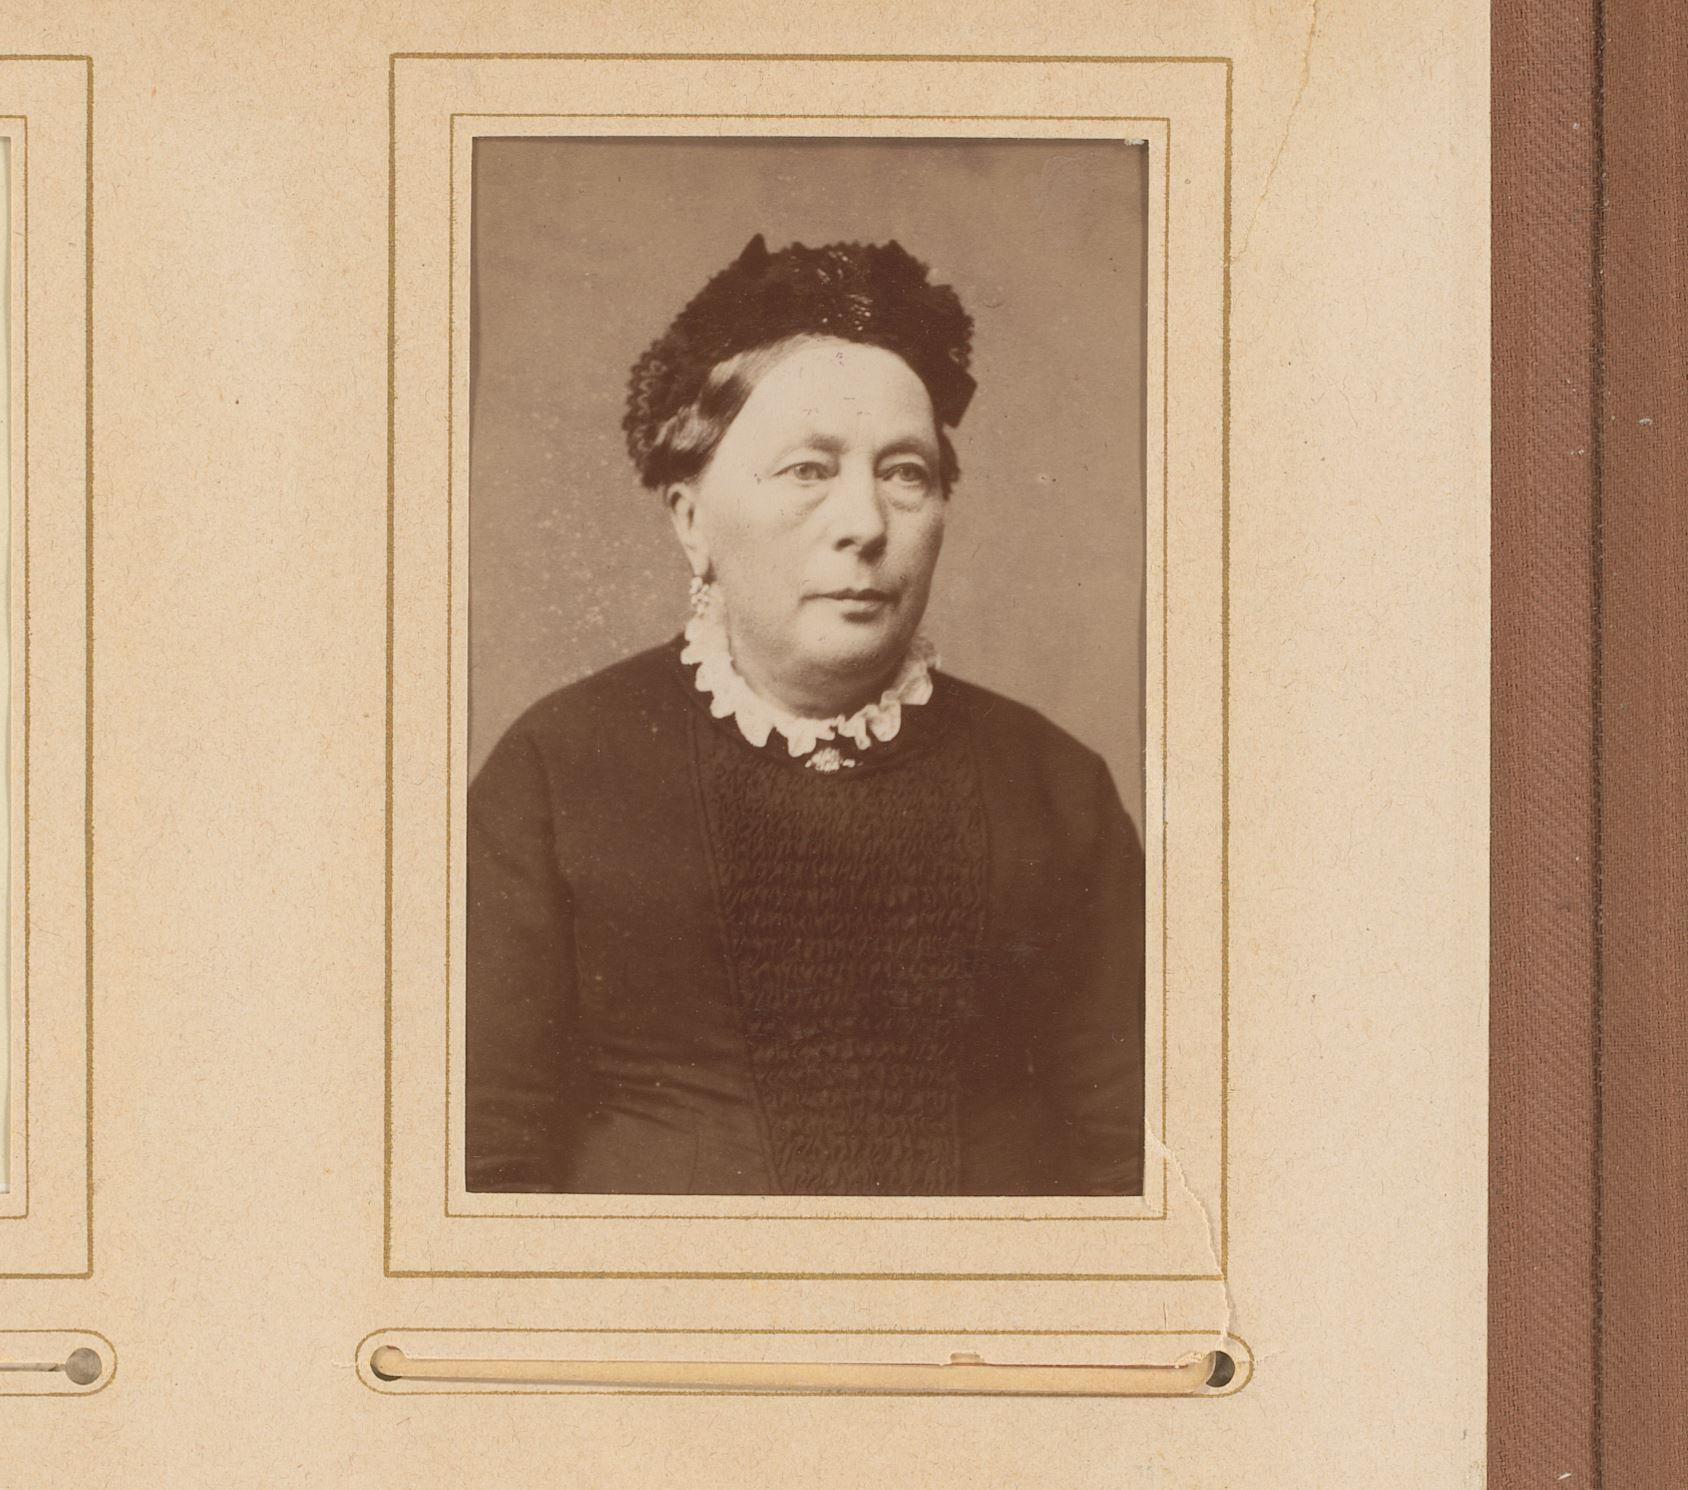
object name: album leaf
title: Portret van een vrouw met muts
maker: b.j. pottjewijd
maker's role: fotograaf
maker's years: 1859-1941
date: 1880-1900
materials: cardboard, photographic support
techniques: albumen print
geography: winschoten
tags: historical persons - bb - woman, head-gear: cap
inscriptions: inscription: ‘Photographie/ B.J. Pottjewijd/ Winschoten’